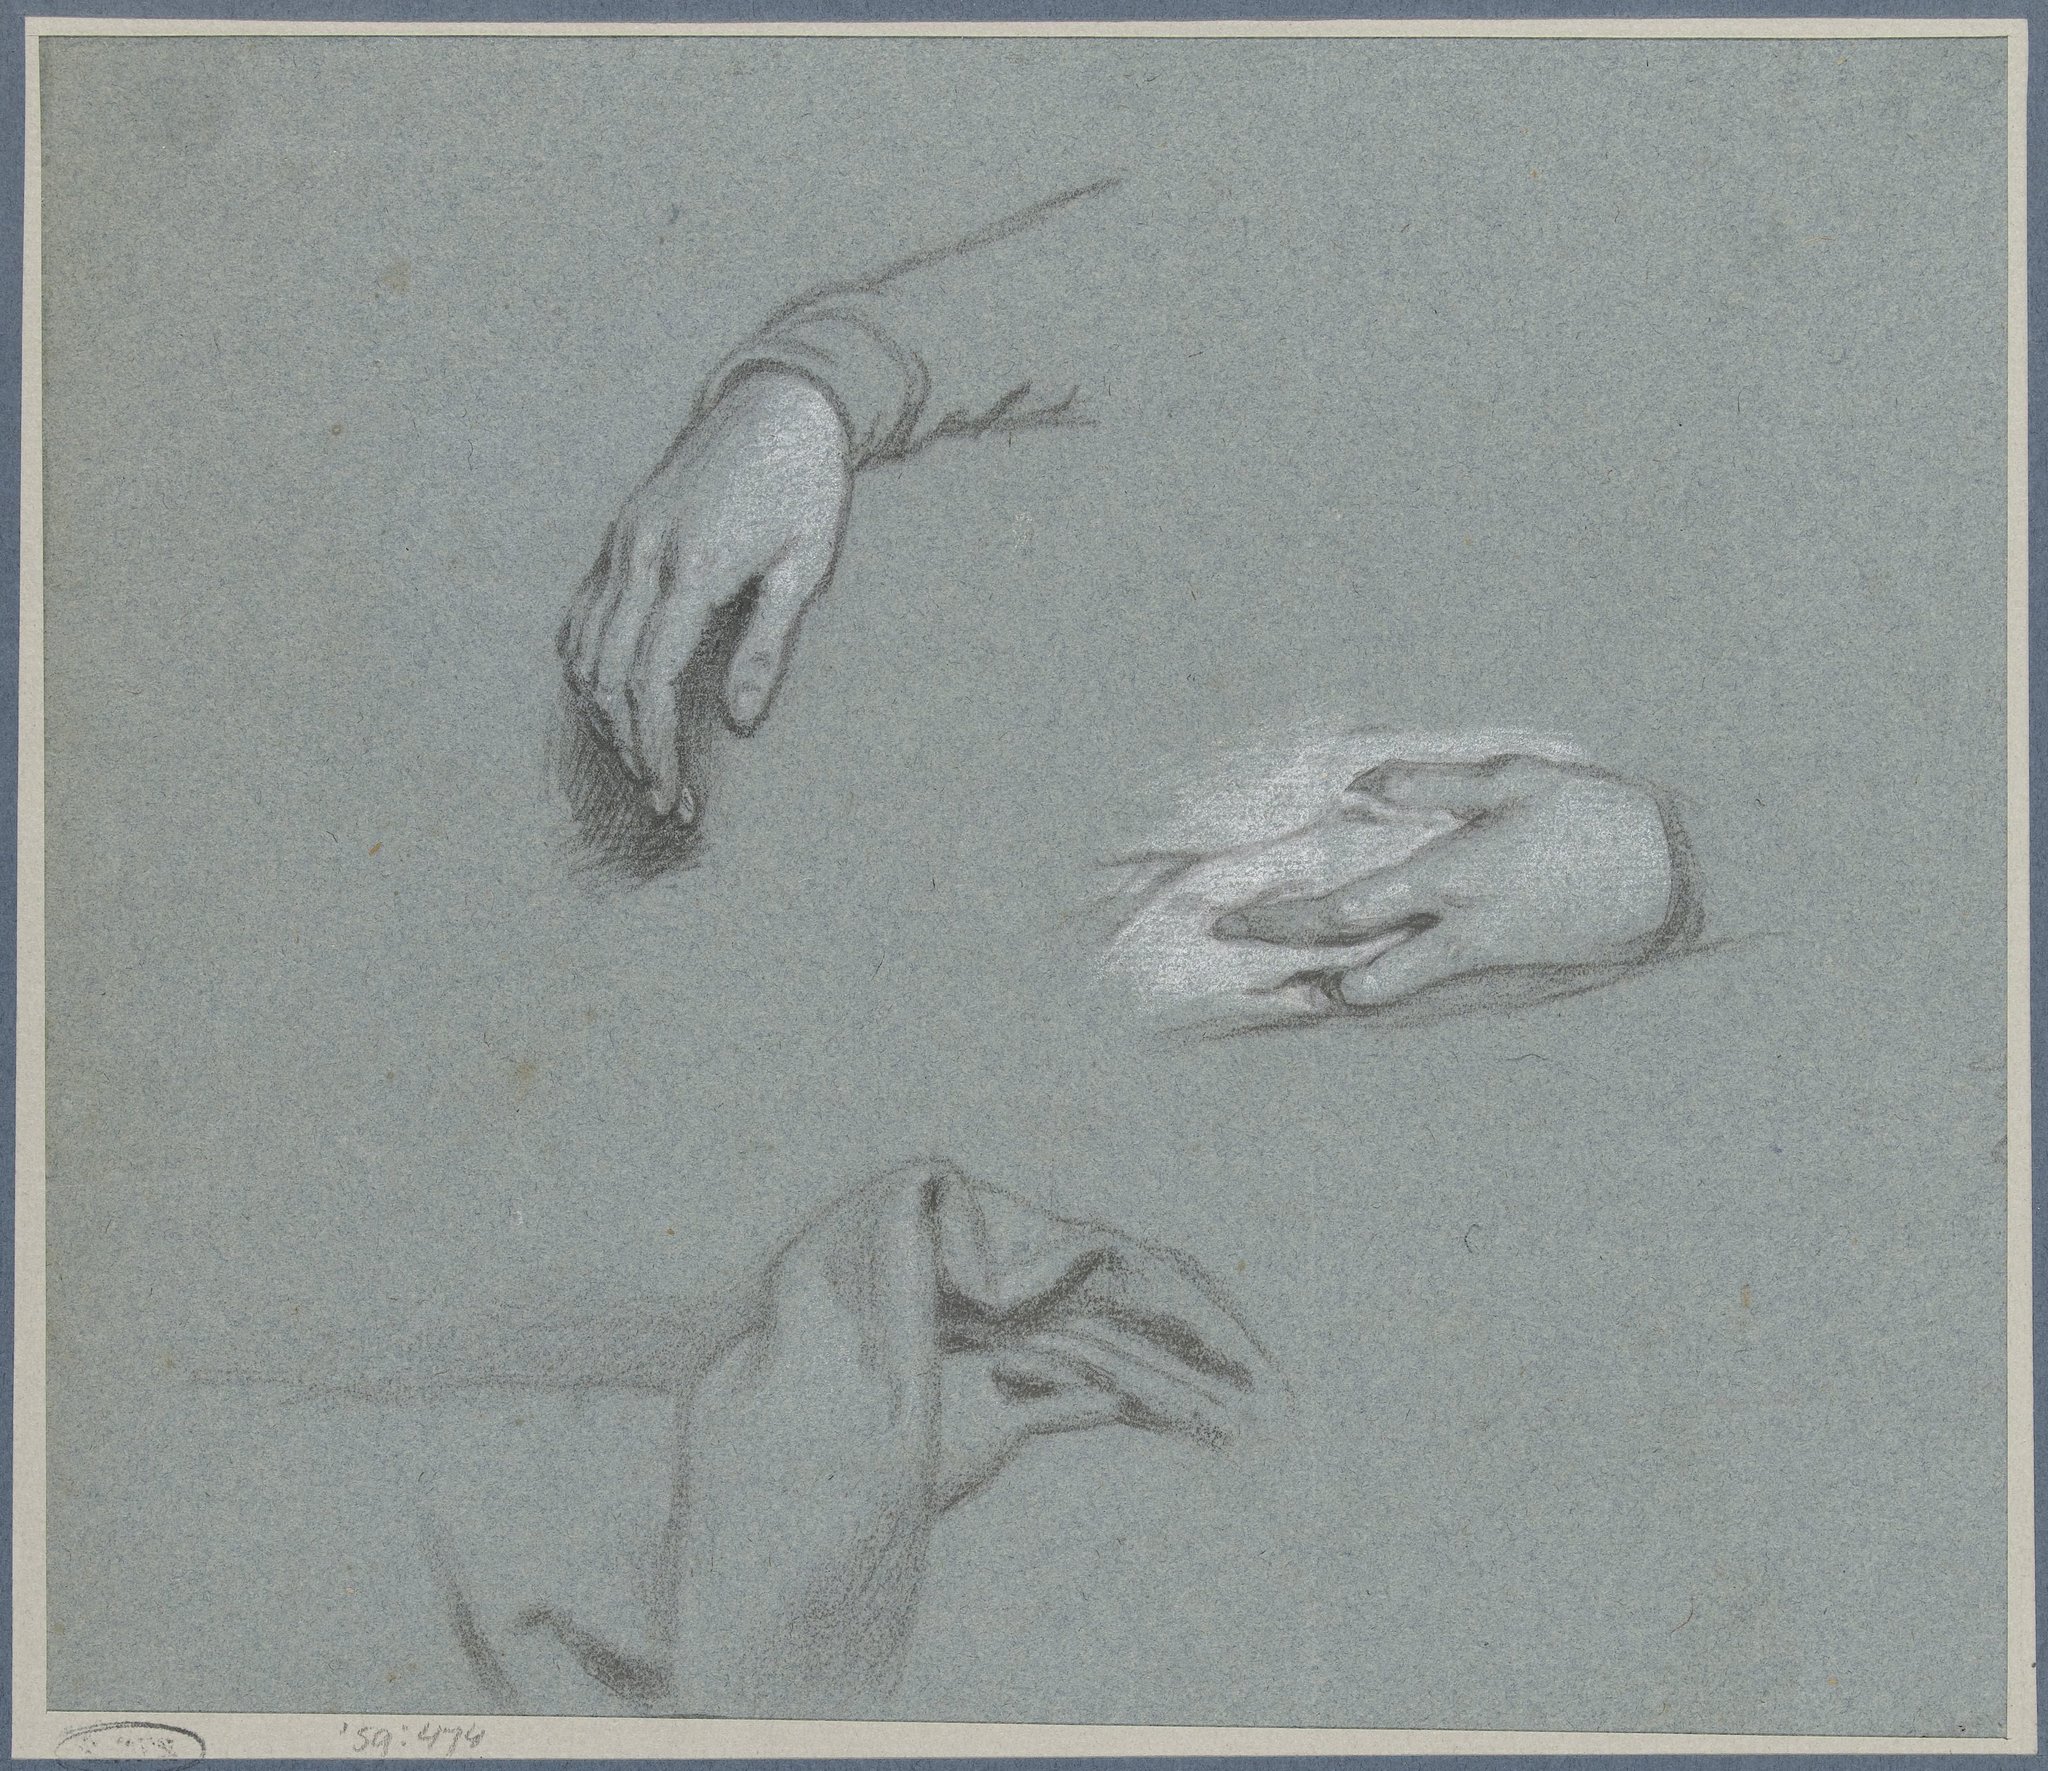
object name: drawing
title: Handen- en draperiestudie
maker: charles howard hodges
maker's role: draughtsman, painter, print maker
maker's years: 1764-1837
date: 1774-1837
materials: chalk, paper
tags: hand, drapery, draped garment, 'gewandgebung'